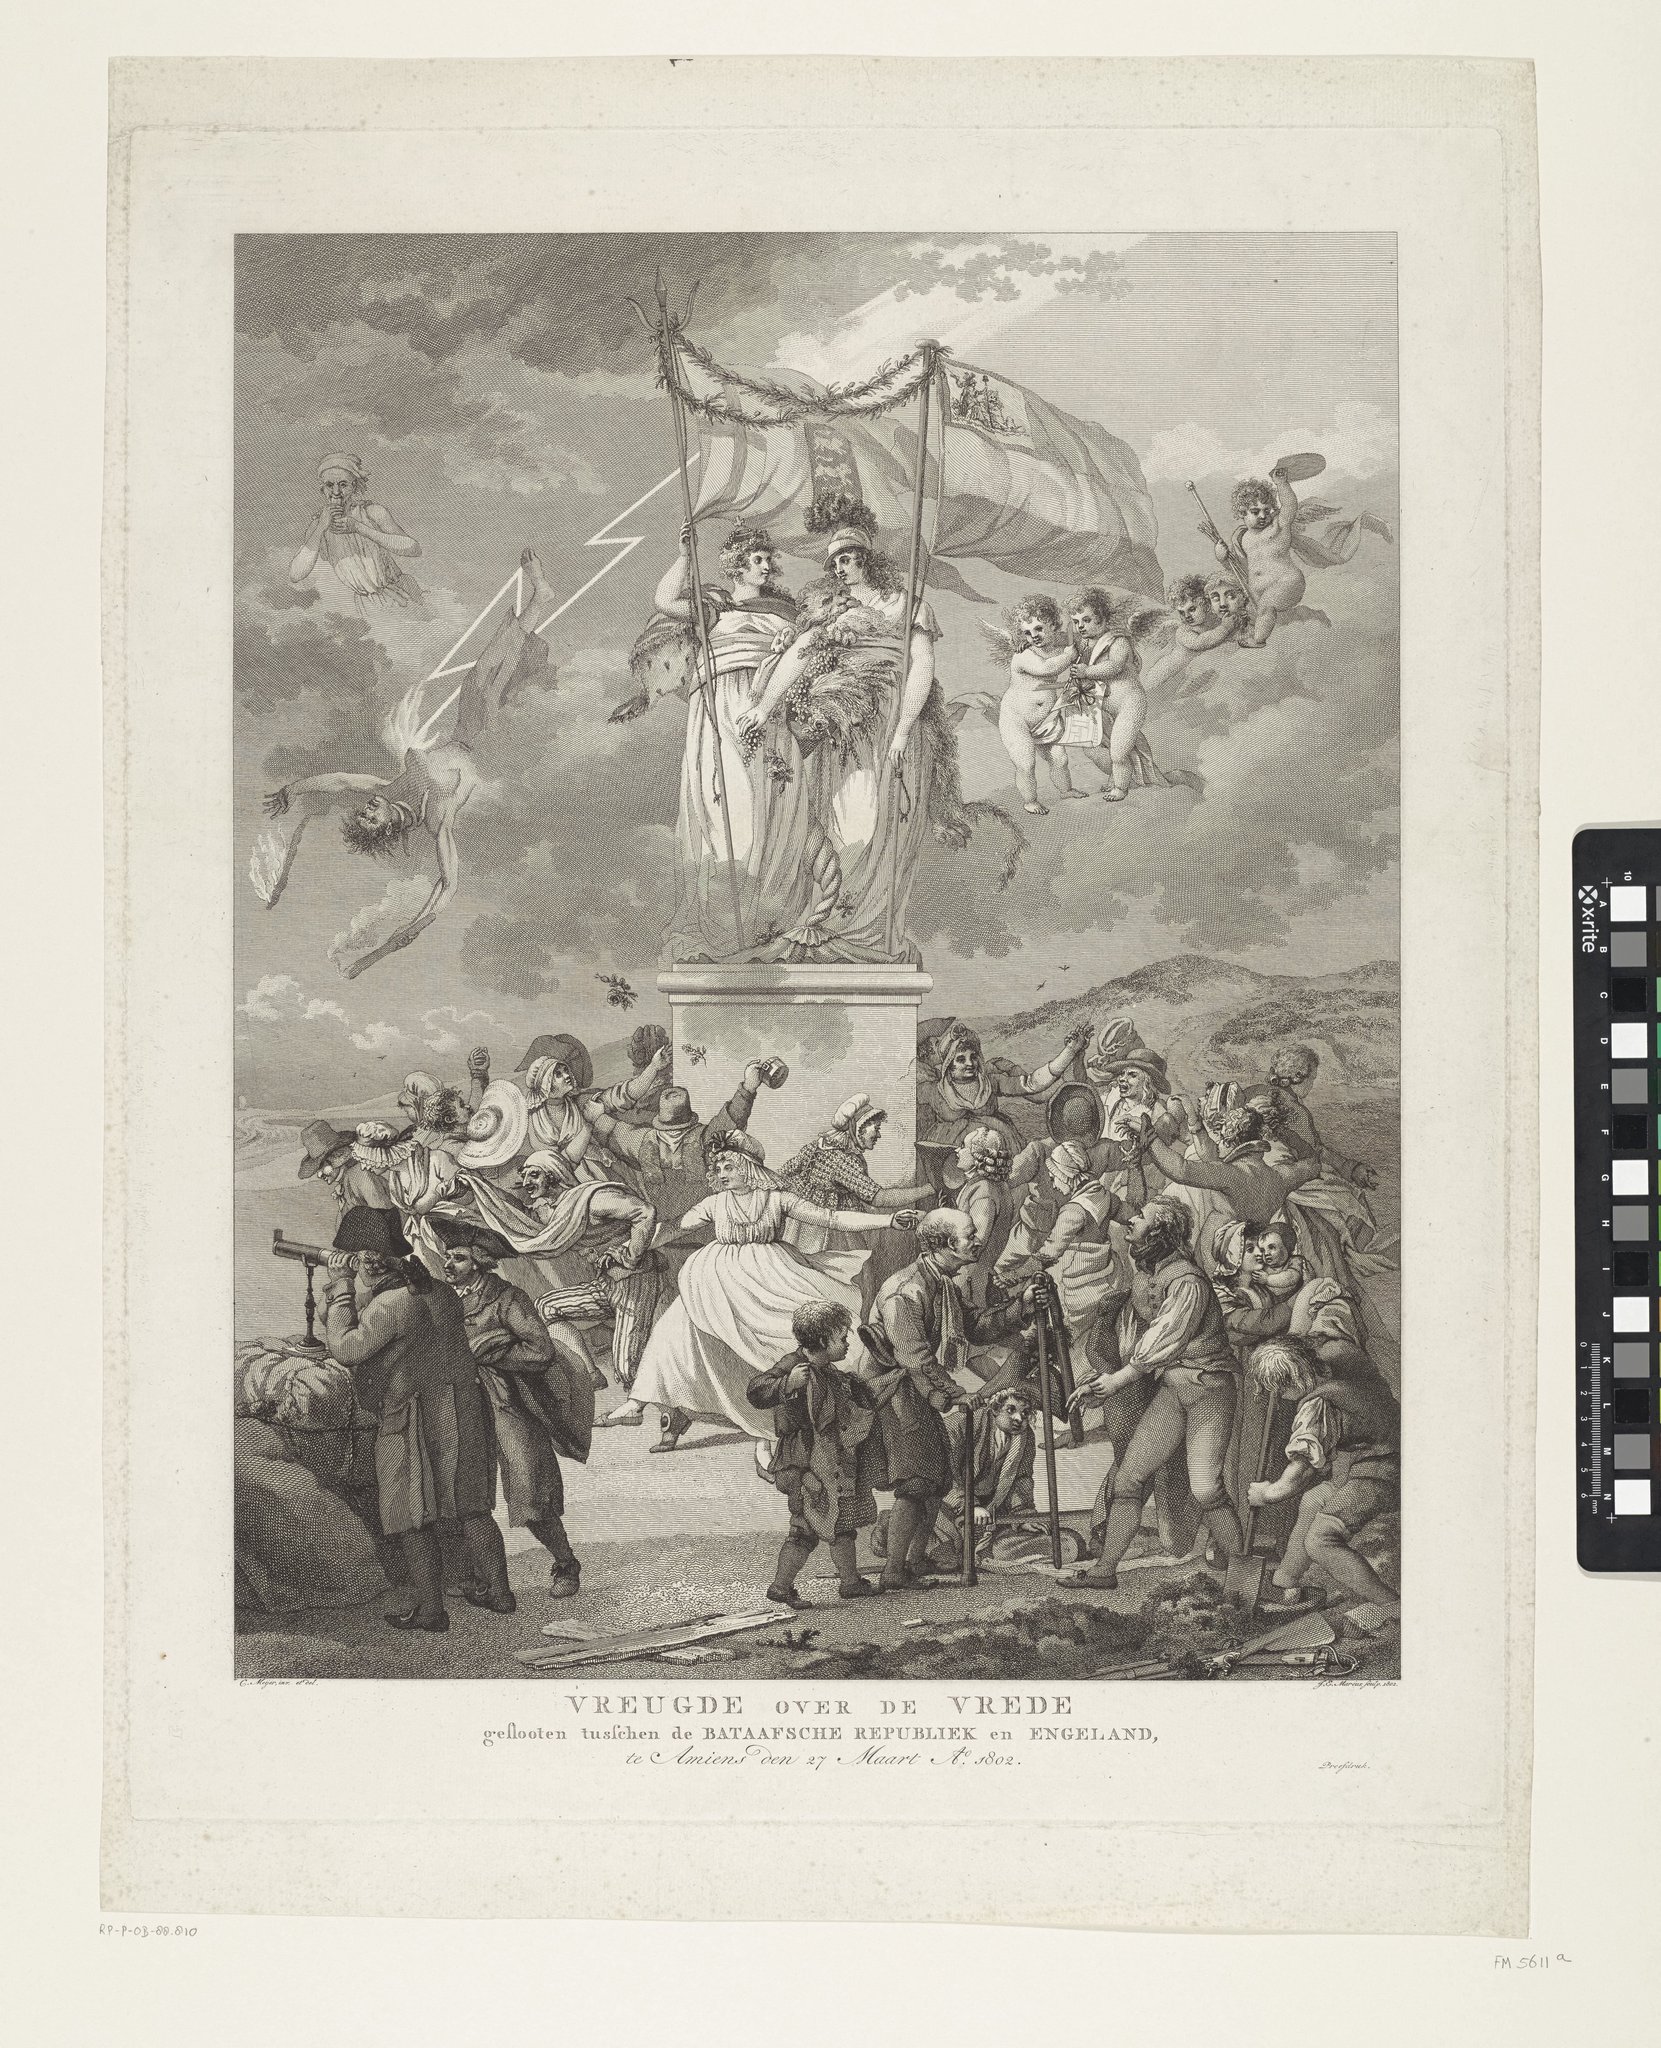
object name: print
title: Vreugde over de Vrede geslooten tusschen de Bataafsche Republiek en Engeland, te Amiens den 27 Maart Ao. 1802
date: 1802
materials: paper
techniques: engraving, etching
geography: netherlands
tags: personifications of countries, nations, states, districts, etc., peace and prosperity, 'pax et abundantia', group dancing around someone or something (folk dancing), telescope, signing of peace treaty, concluding the peace, netherlands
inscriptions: collector's mark: Lugt 2228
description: Vreugde over de vrede gesloten te Amiens op 27 maart 1802, tussen de Bataafse Republiek en Frankrijk en Groot-Brittannië. Op een voetstuk staan de Britse en Nederlandse maagden met hun vlaggen, tussen hen in een hoorn van overvloed met druiven en graan. Om het monument danst het uitgelaten volk, links tuurt een man met een verrekijker over zee, rechts worden wapens begraven en gebruikt om brood te snijden.